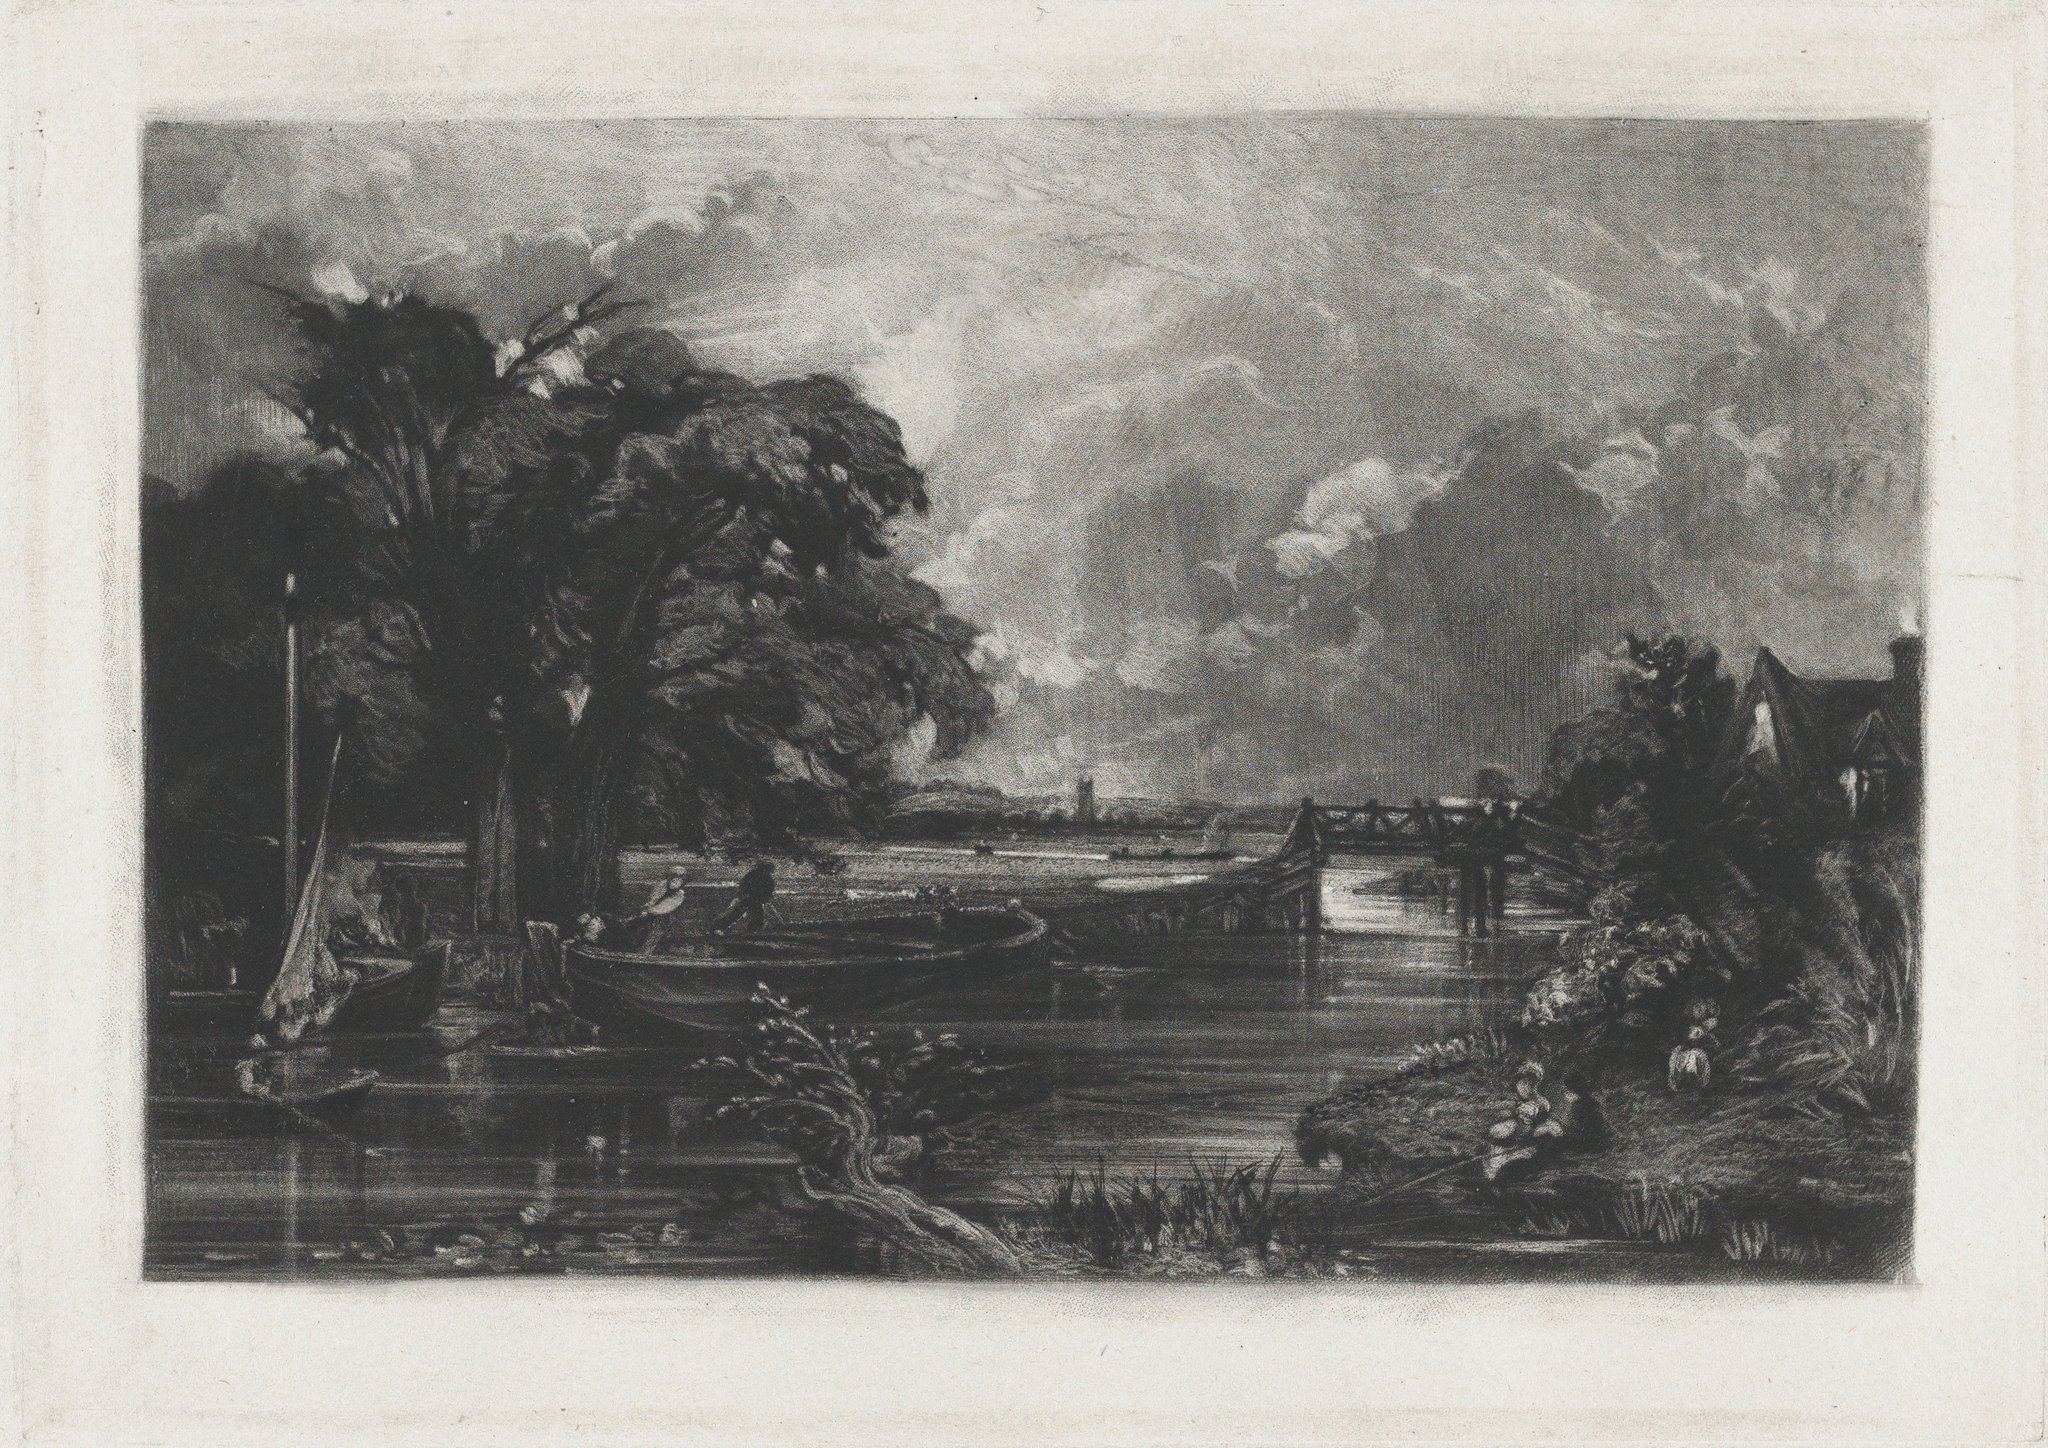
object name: print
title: River Stour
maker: david lucas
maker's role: artist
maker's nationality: british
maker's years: 1802-1881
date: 1830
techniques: mezzotint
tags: rivers,landscapes,trees,boats